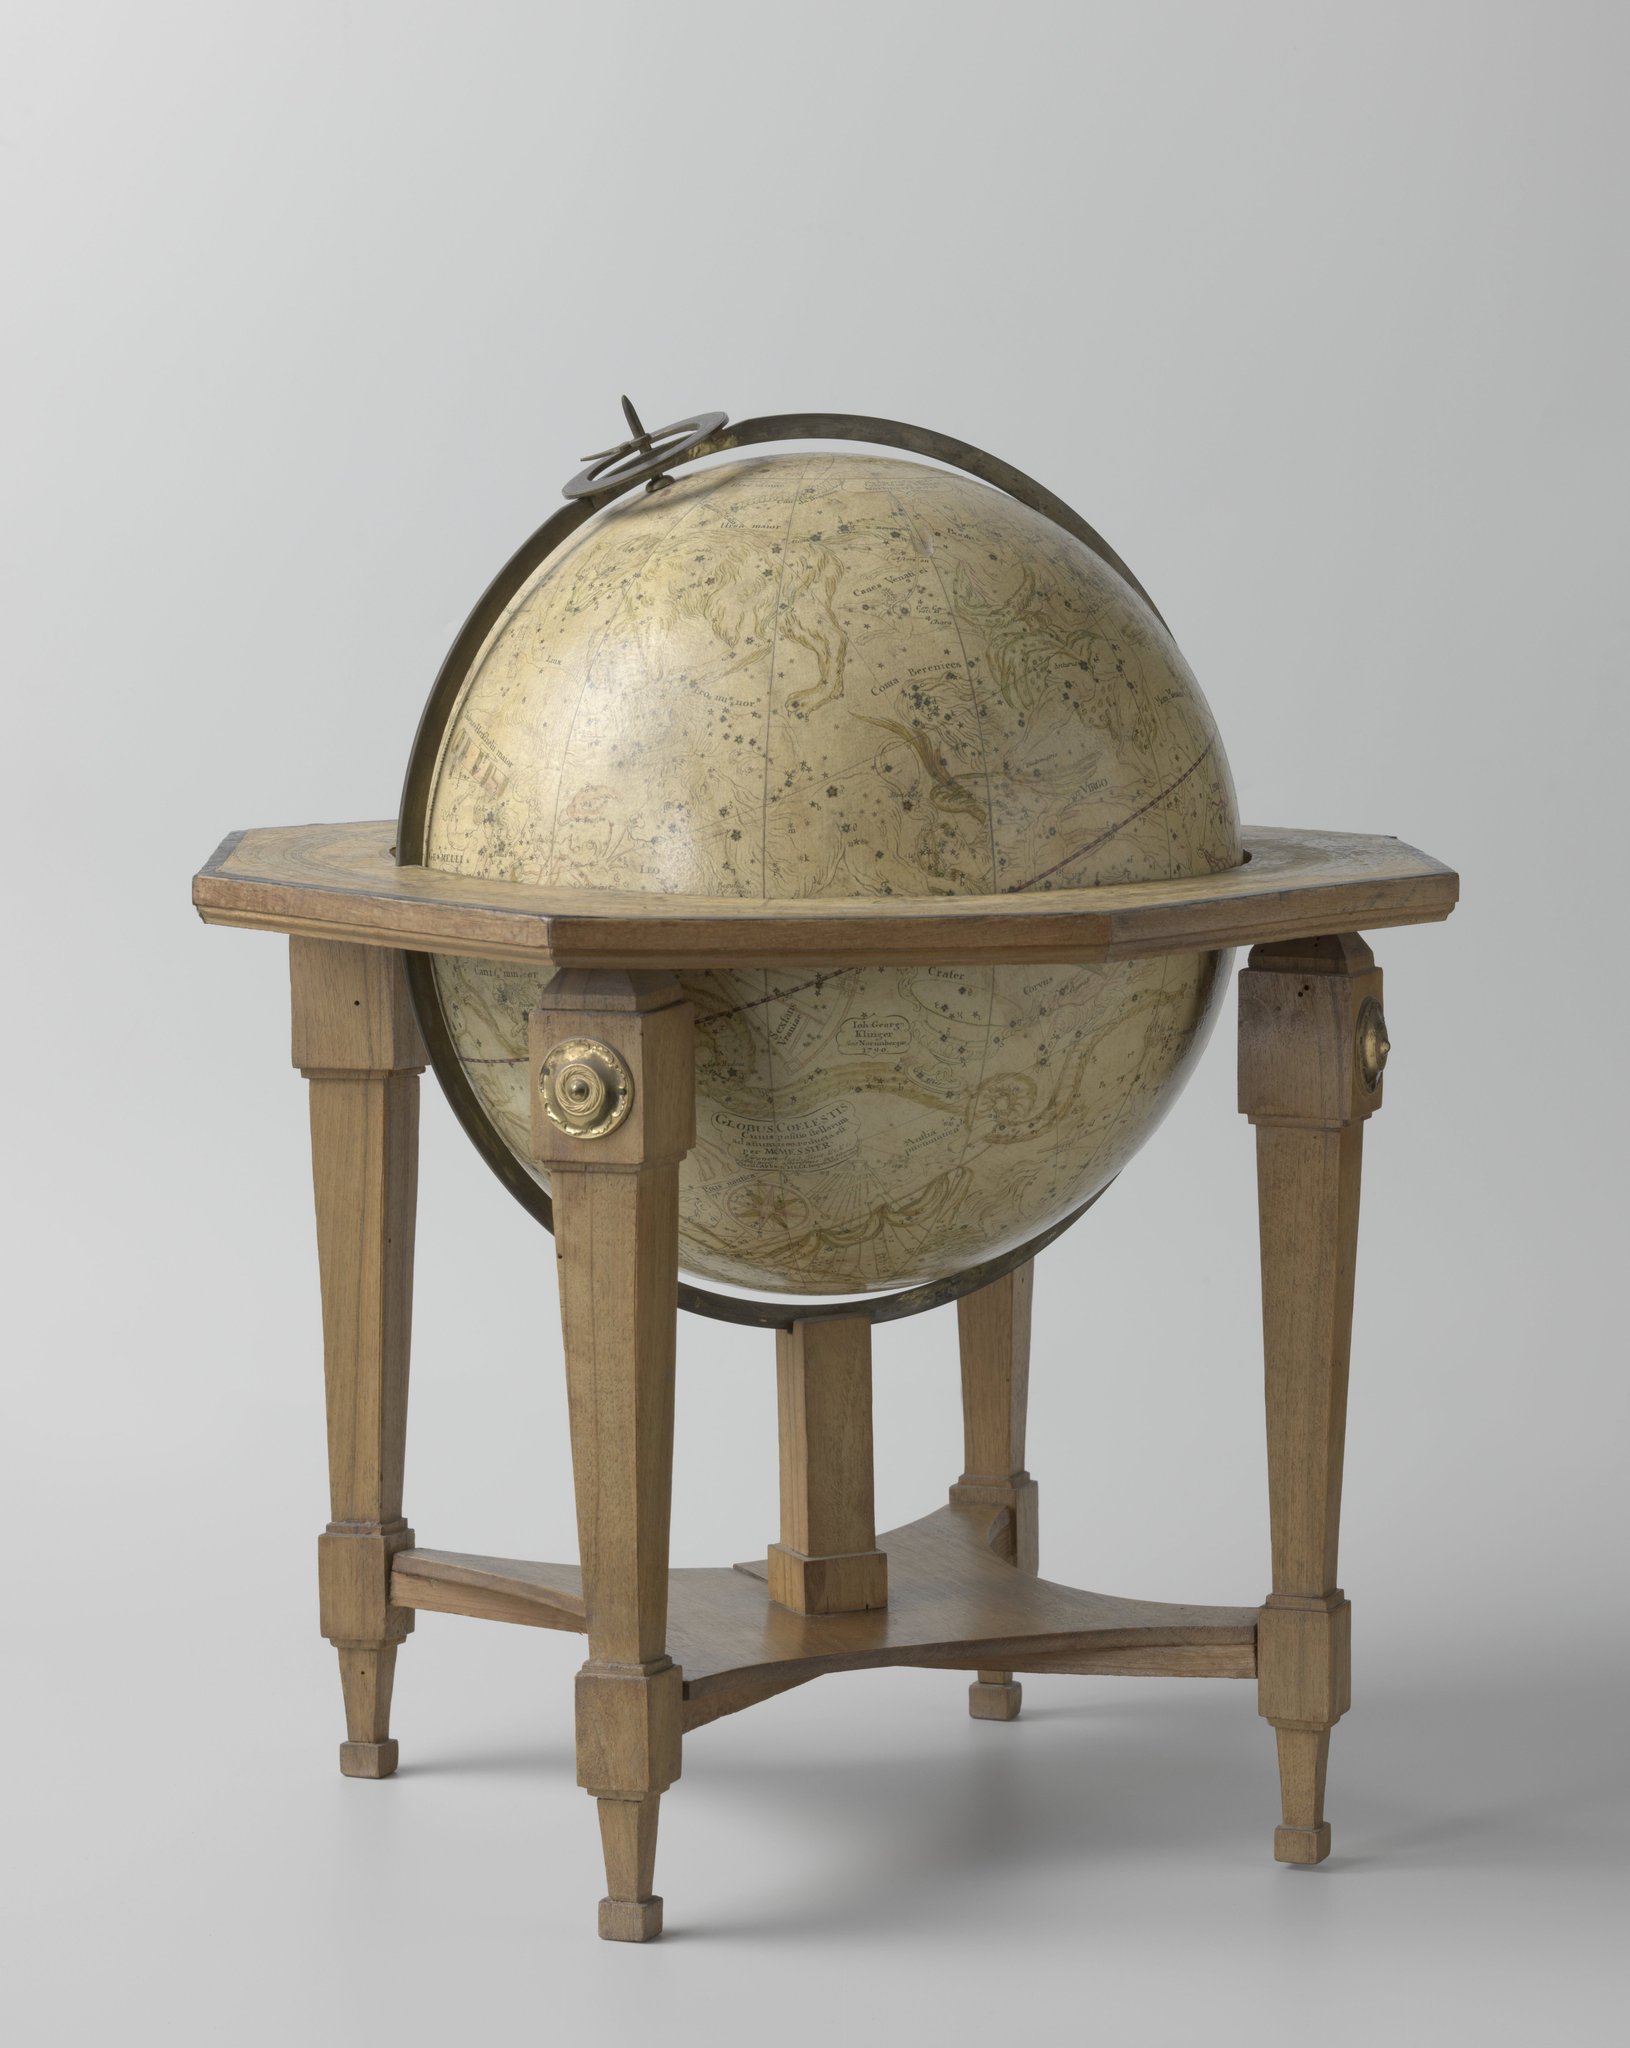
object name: globe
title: Aardglobe in stoel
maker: johann georg klinger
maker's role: draughtsman, print maker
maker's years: 1764-1806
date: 1792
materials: wood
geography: nuremberg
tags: james cook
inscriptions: : ‘GLOBUS TERRESTRIS quam ex novissimis, subsidiis, mappis geographicis, observationibusque construxit necnon itineribus Cookii, Duncanii, Hearnii etc. ornavit Ionnes Georgius Klinger Chalcogr: Norimbergae Ao 1792.’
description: Verschillende routes en expedities staan op deze globe aangetekend: De drie ontdekkingsreizen van de Pacific Ocean van James Cook, (1768-1780), de noordkust van Amerika door Samual Hearne (1770-1772) en Charles Duncan's reis naar de Pacific (1788-1789).